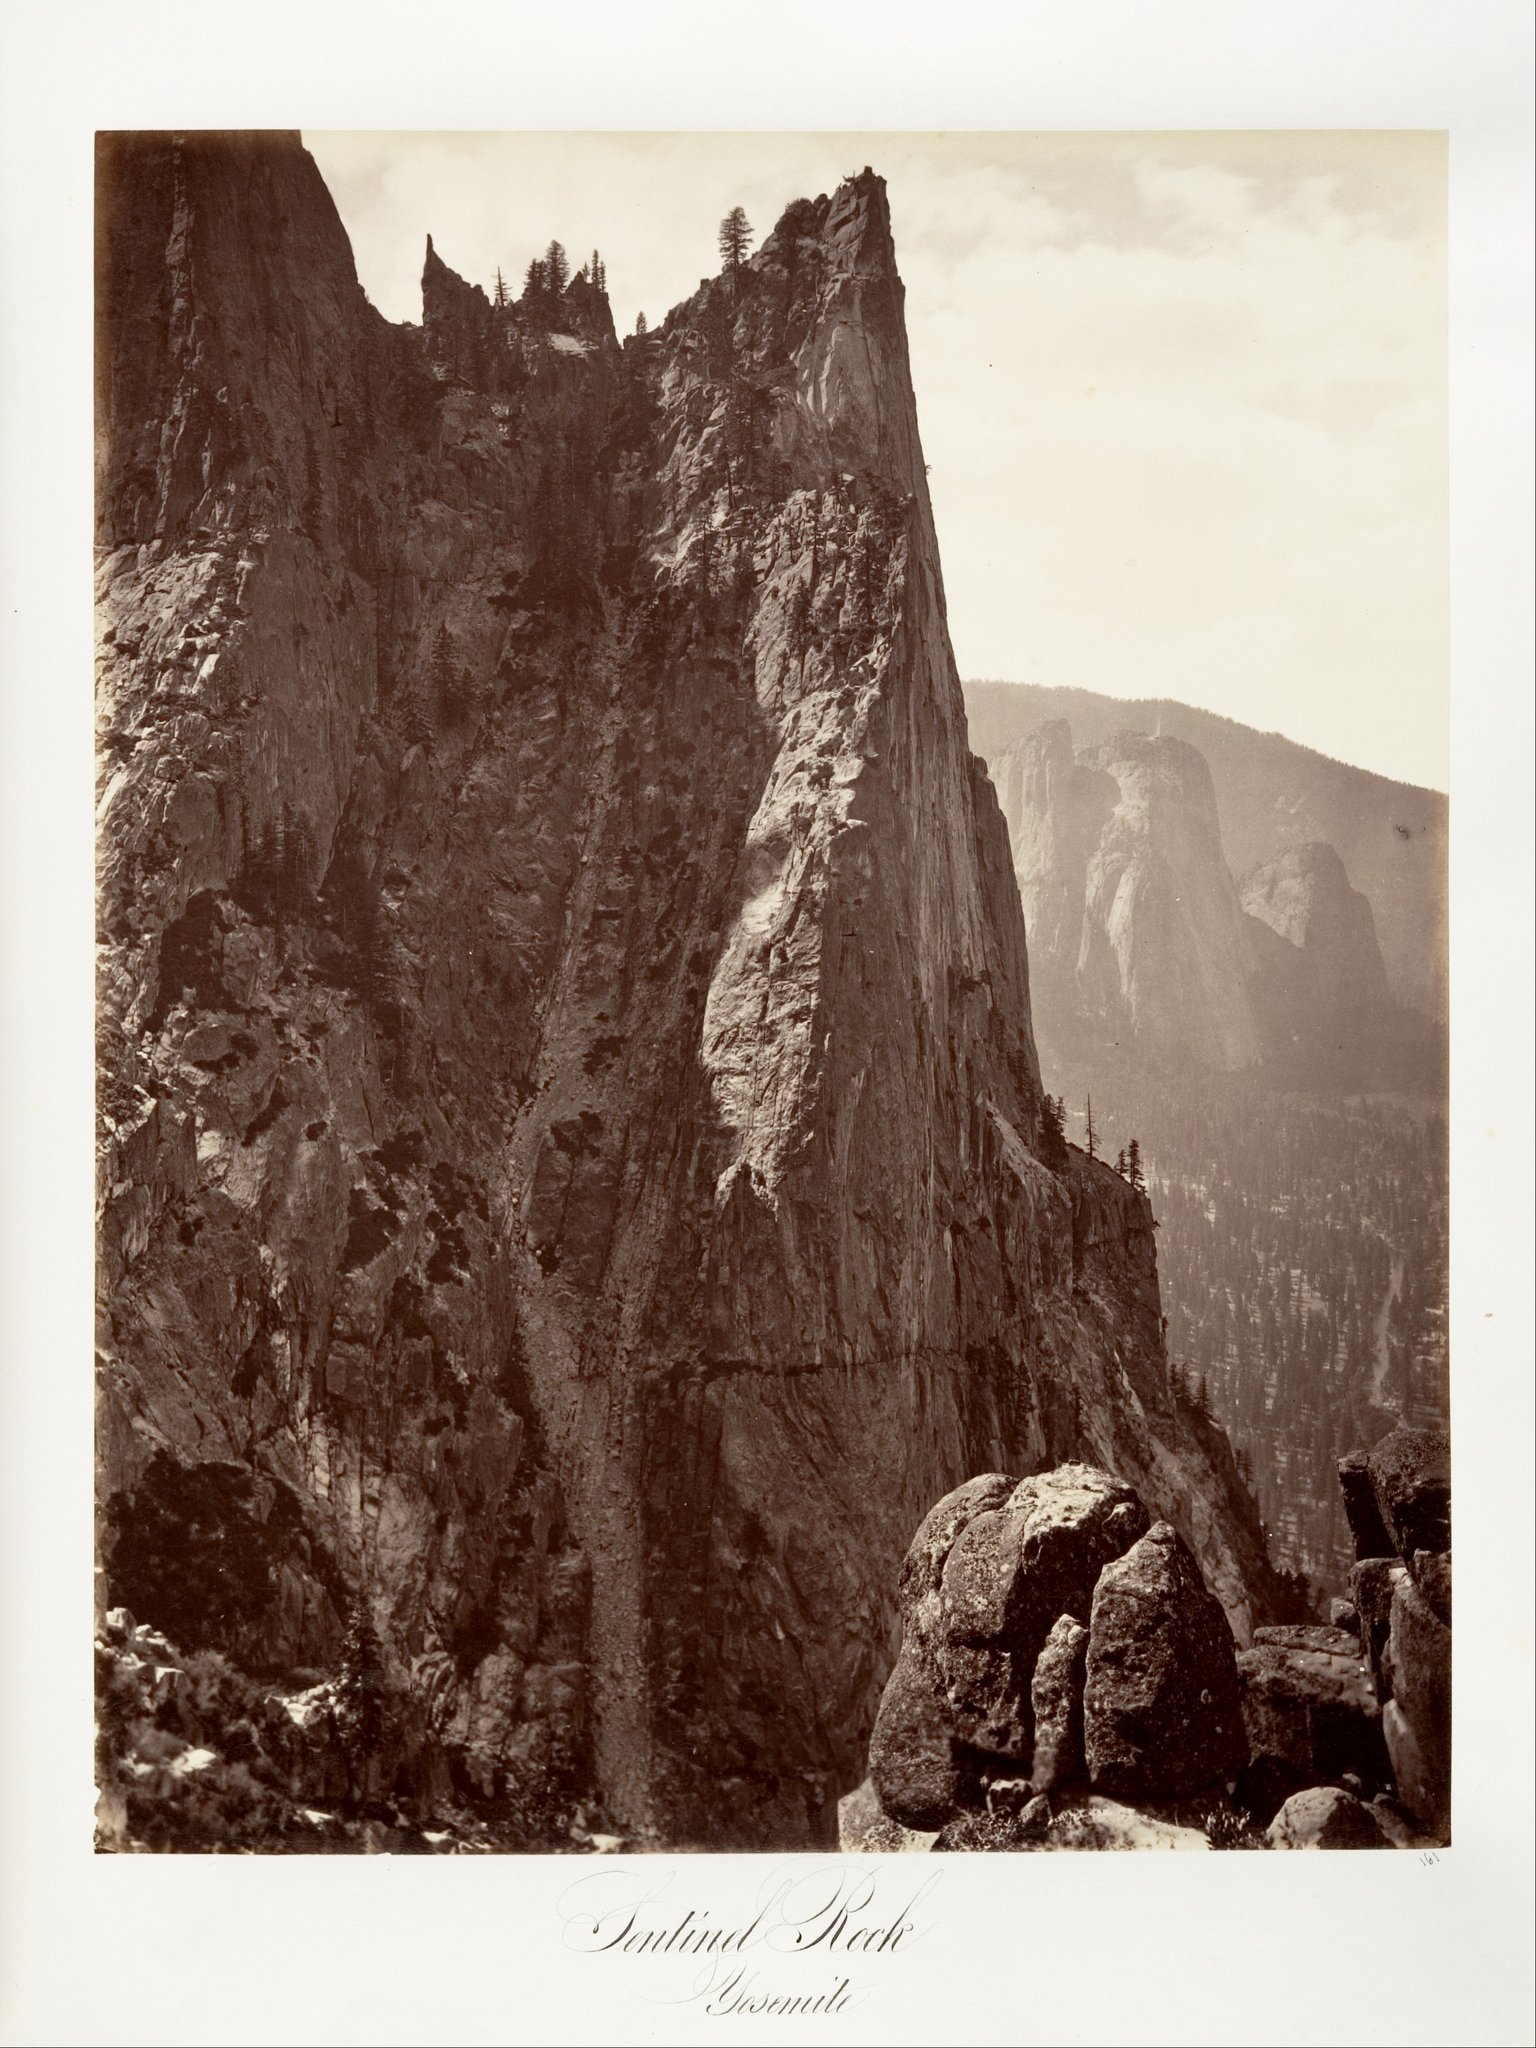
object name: photograph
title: Sentinel Rock, Yosemite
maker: carleton e. watkins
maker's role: artist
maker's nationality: american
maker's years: 1829-1916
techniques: albumen silver print, glass negative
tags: mountains,landscapes